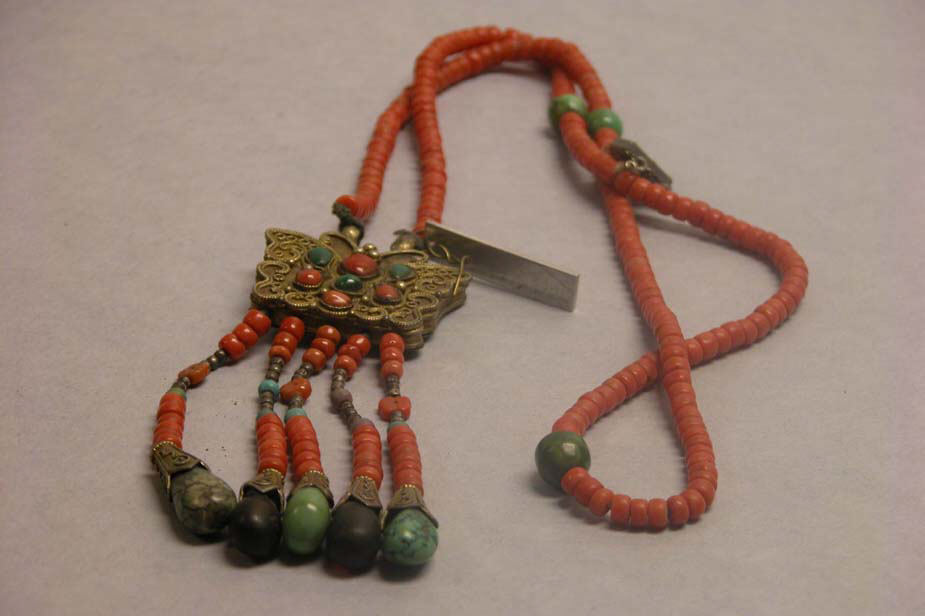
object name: necklace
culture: tibetan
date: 1801-1900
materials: jade, silver